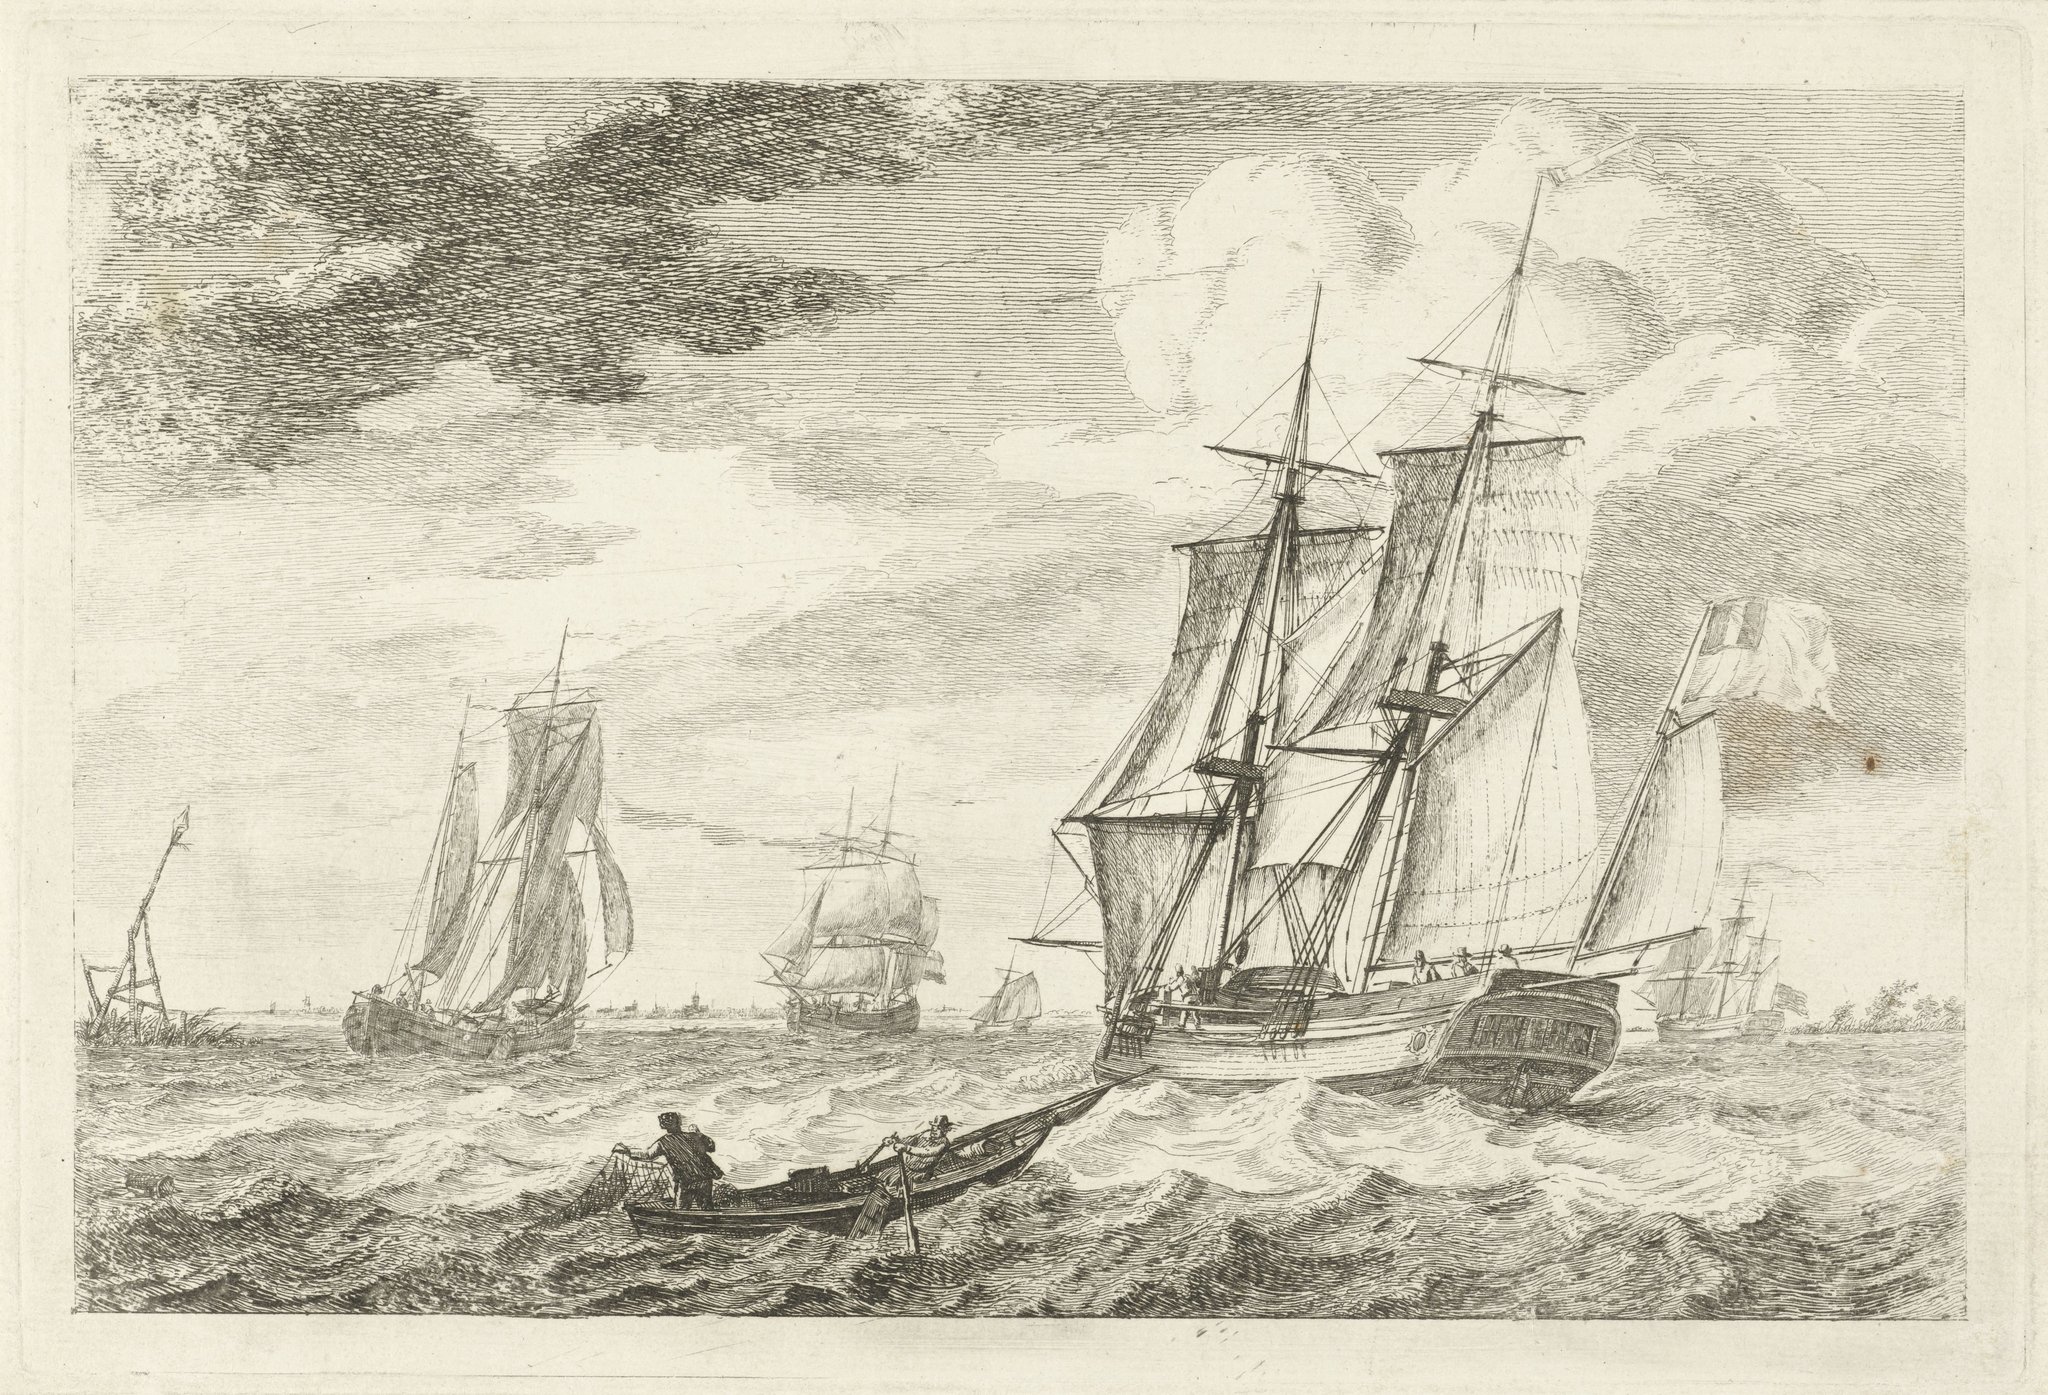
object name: print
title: Diverse boten op de golven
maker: gerrit groenewegen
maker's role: draughtsman, print maker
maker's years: 1754-1826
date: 1793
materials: paper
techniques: etching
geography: rotterdam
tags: ships (in general)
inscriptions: collector's mark: Lugt 2228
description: Zeegezicht met zeilschepen en op de voorgrond een sloep met twee figuren. Door een van de mannen in de sloep wordt geroeid, terwijl de andere een visnet uitwerpt bij het roer. Deze prent maakt deel uit van een serie van vijf prenten met verschillende zeilschepen.